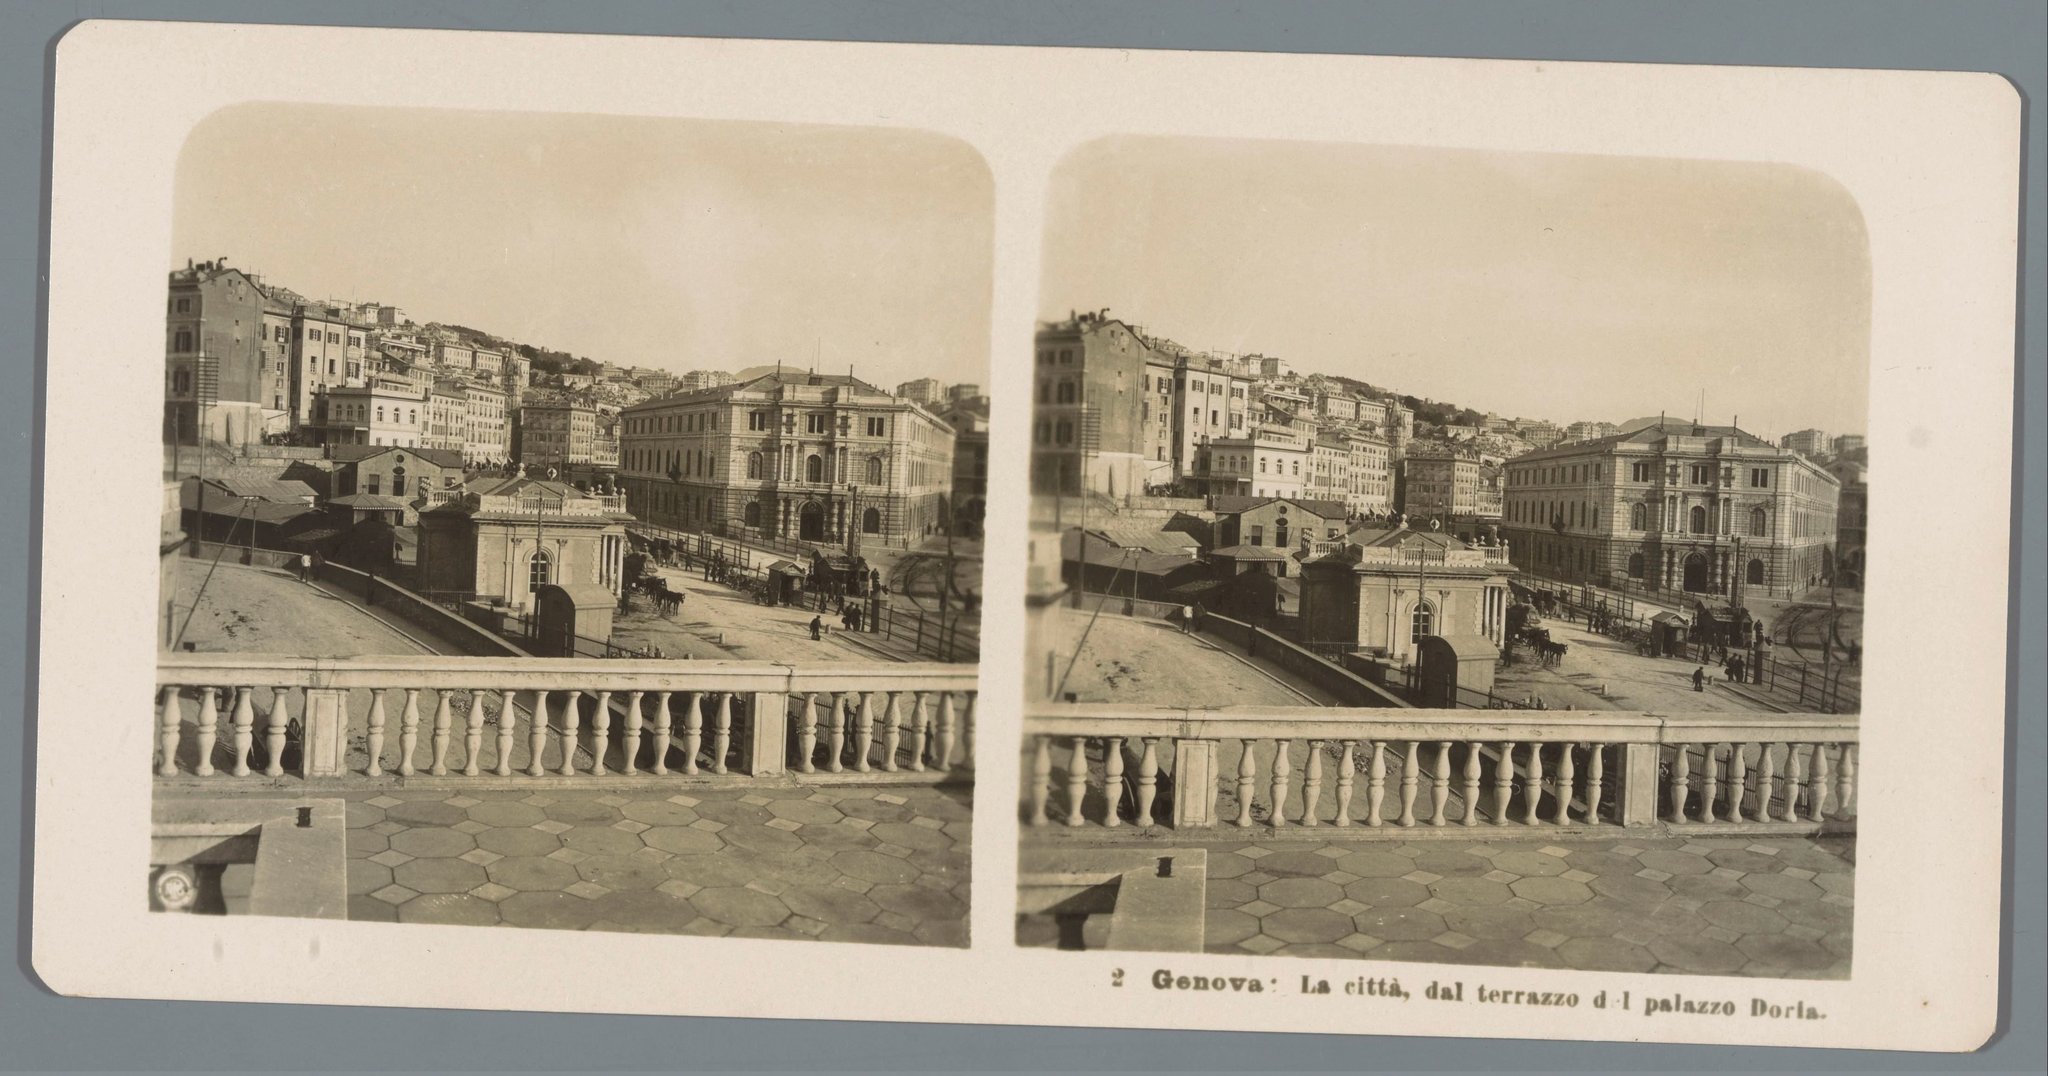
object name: stereograph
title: Gezicht op gebouwen te Genua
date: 1900-1910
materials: cardboard, photographic support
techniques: gelatin silver print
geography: genoa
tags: housing, façade (of house or building)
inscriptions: inscription: ‘NPG’, number: ‘2’